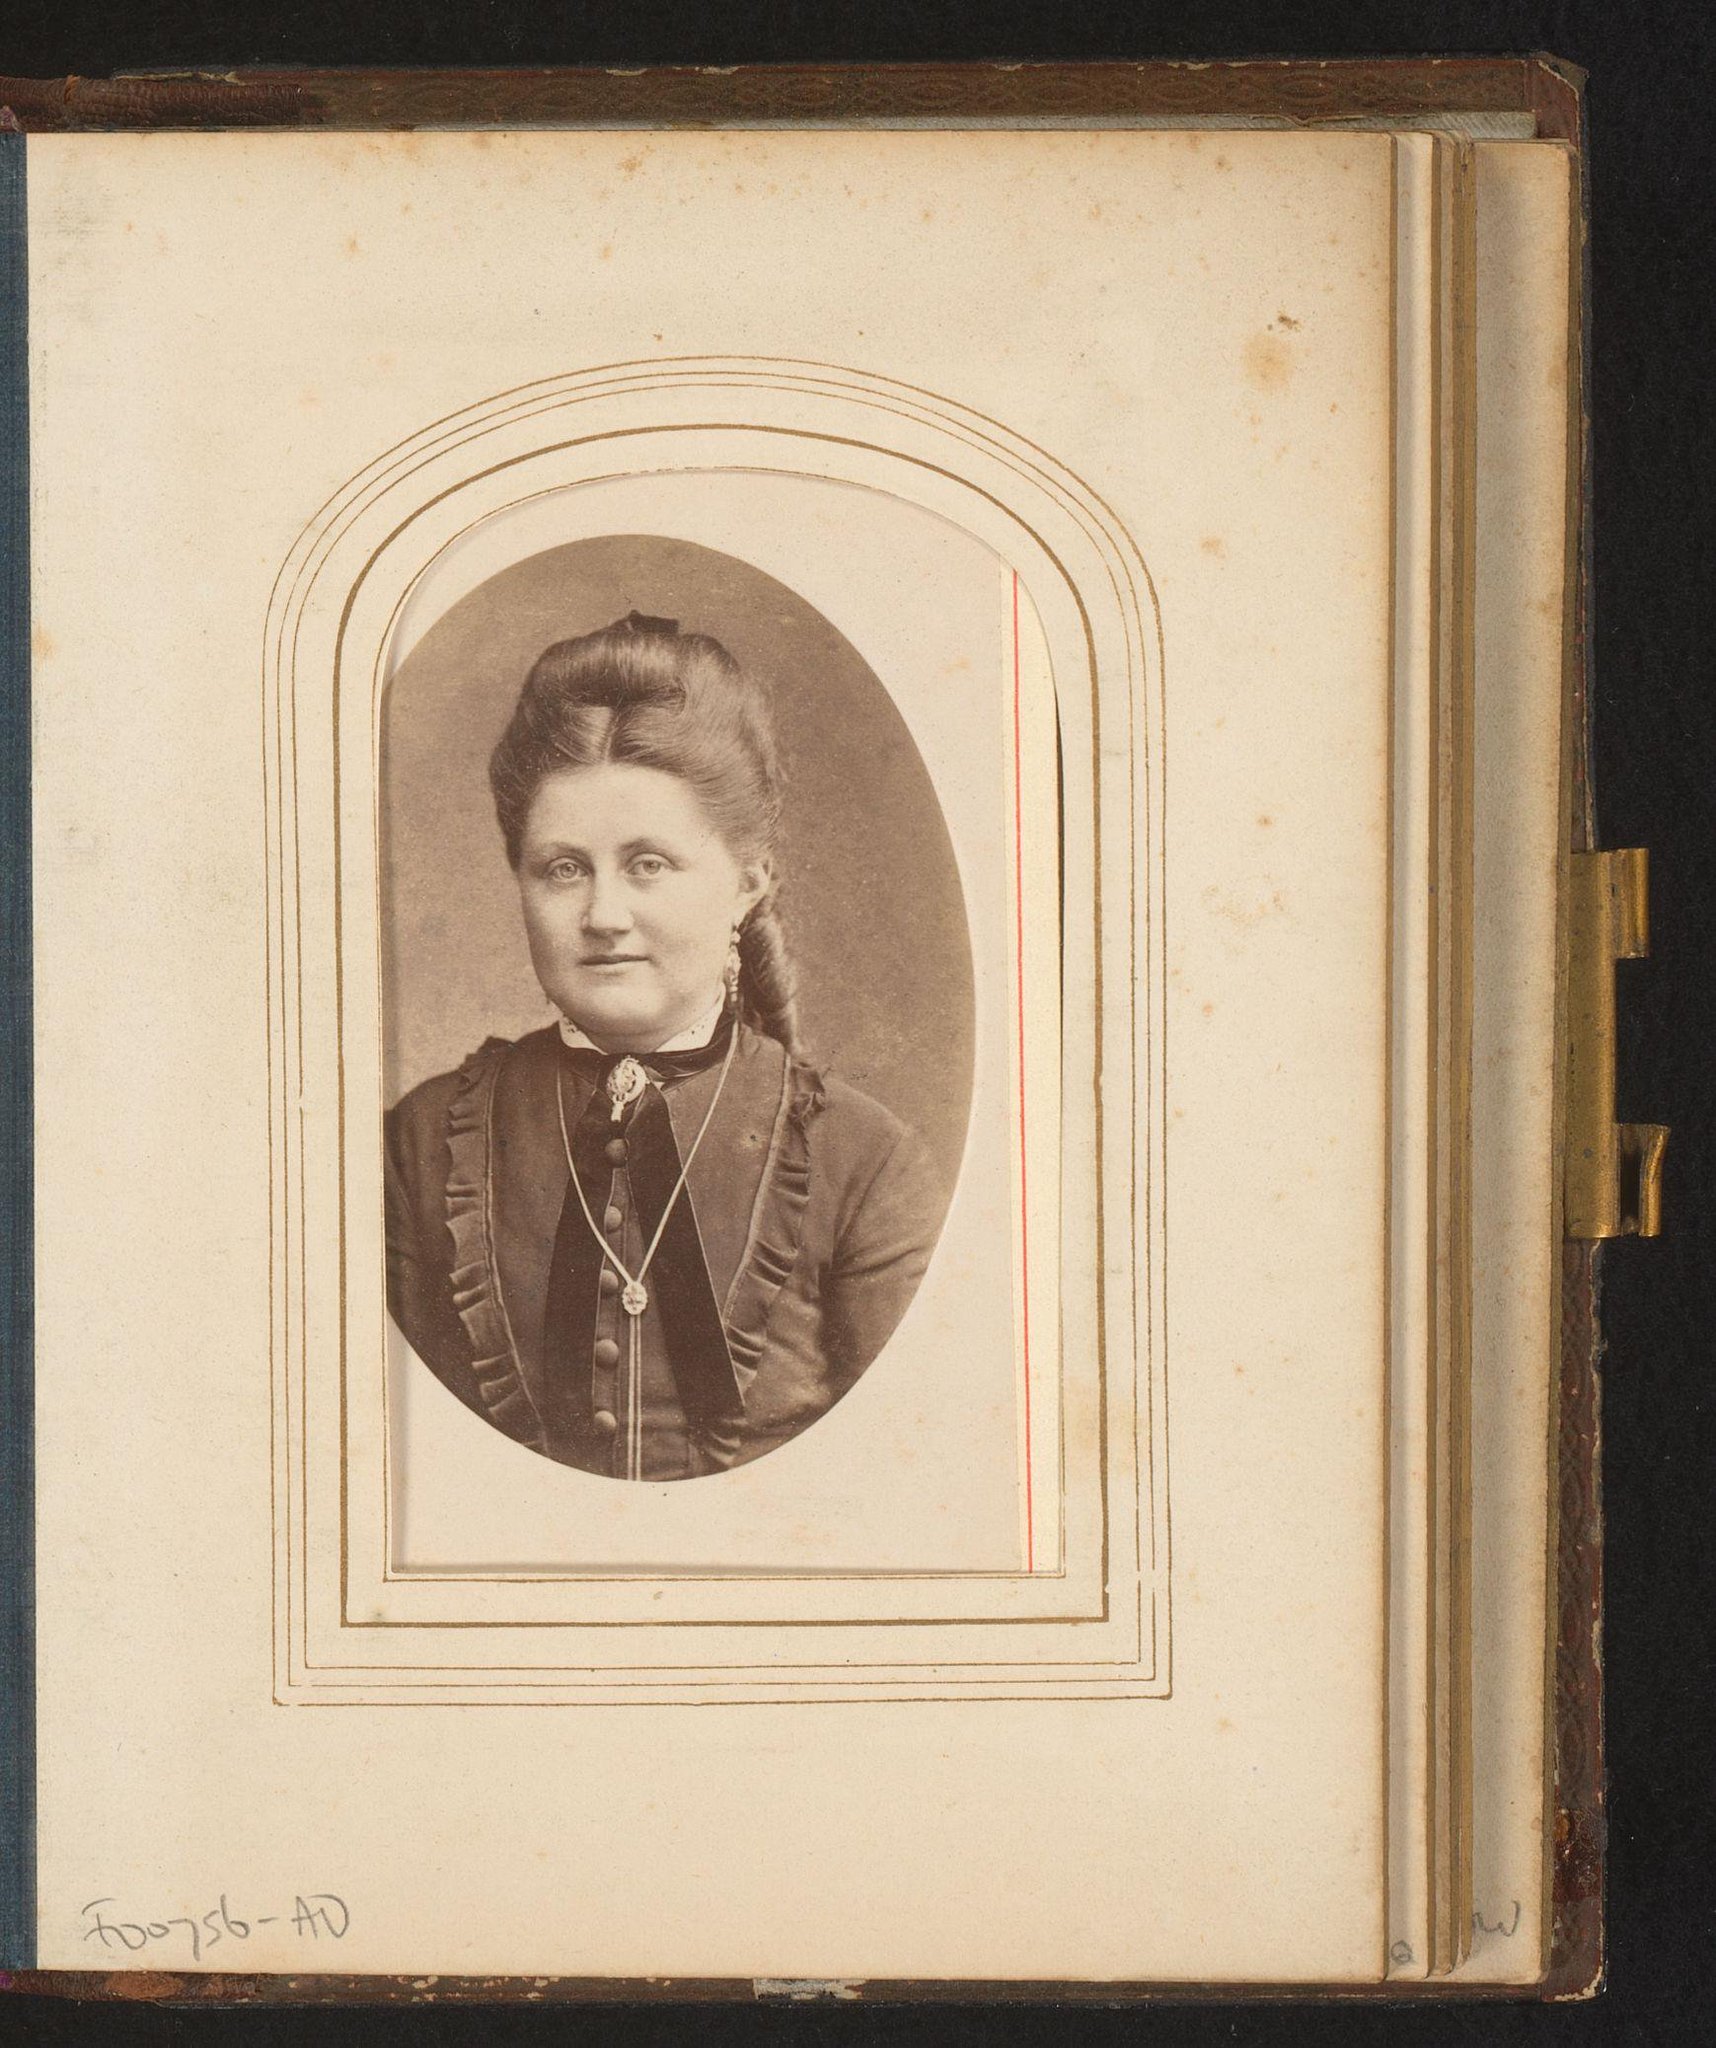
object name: album leaf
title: Portret van een vrouw met halsketting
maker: friedrich julius von kolkow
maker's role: fotograaf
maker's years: 1839-1914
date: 1876-1900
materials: cardboard, photographic support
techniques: albumen print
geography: groningen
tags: historical persons - bb - woman, necklace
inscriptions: inscription: ‘wereld-tentoonstelling/ Philadelphia/ groote - prijs medaille./ 1876./ 1873/ VERDIENST-MEDAILLE WEENEN./ Zilverne Voigtländer Medaille Weenen 1875./ Zilverne PrijsMedaillen/ te/ Amsterdam 1866, Groningen 1869, Hoogezand 1872, Appingedam 1874./ Veendam 1873. Winsum 1872./ Warffum 1874./ Fr. Jul. von Kolkow/ Hof-Photograaf/ Z.K.H. Prins Hendrik der Nederlanden/ Groningen.’